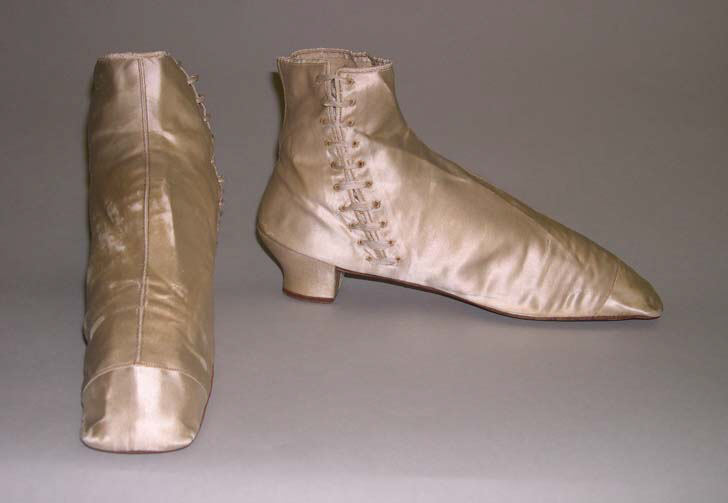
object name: boot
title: Boots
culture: american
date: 1860-1869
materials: leather, silk, wood